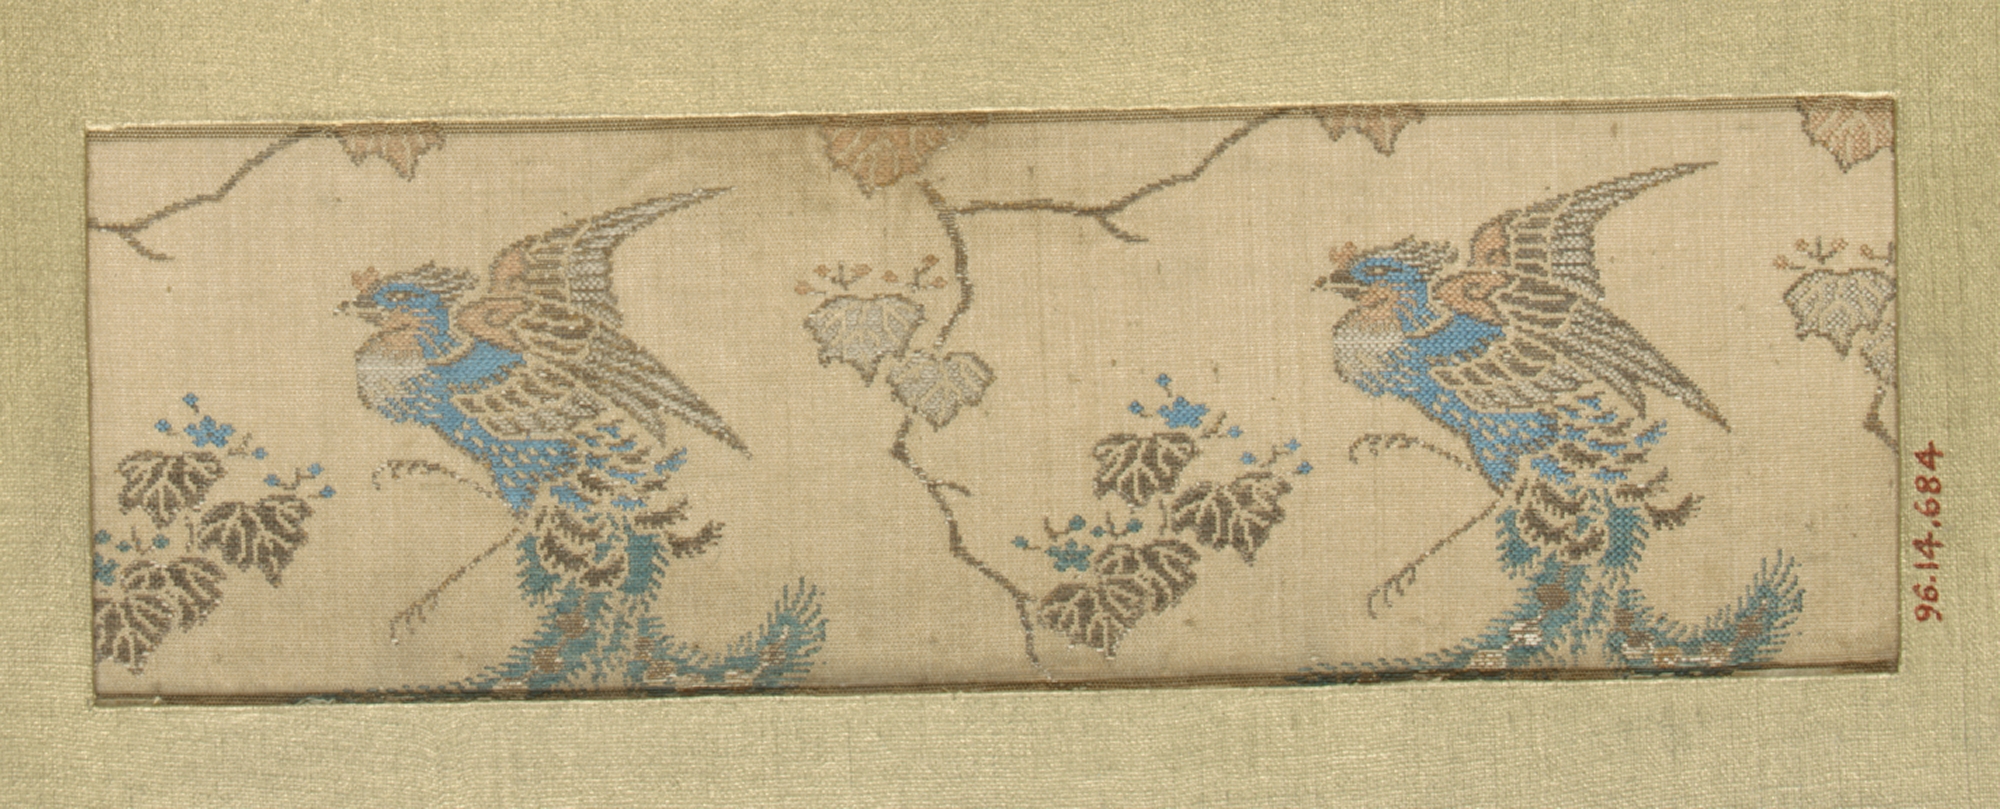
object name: piece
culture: japanese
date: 1701-1900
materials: silk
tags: leaves